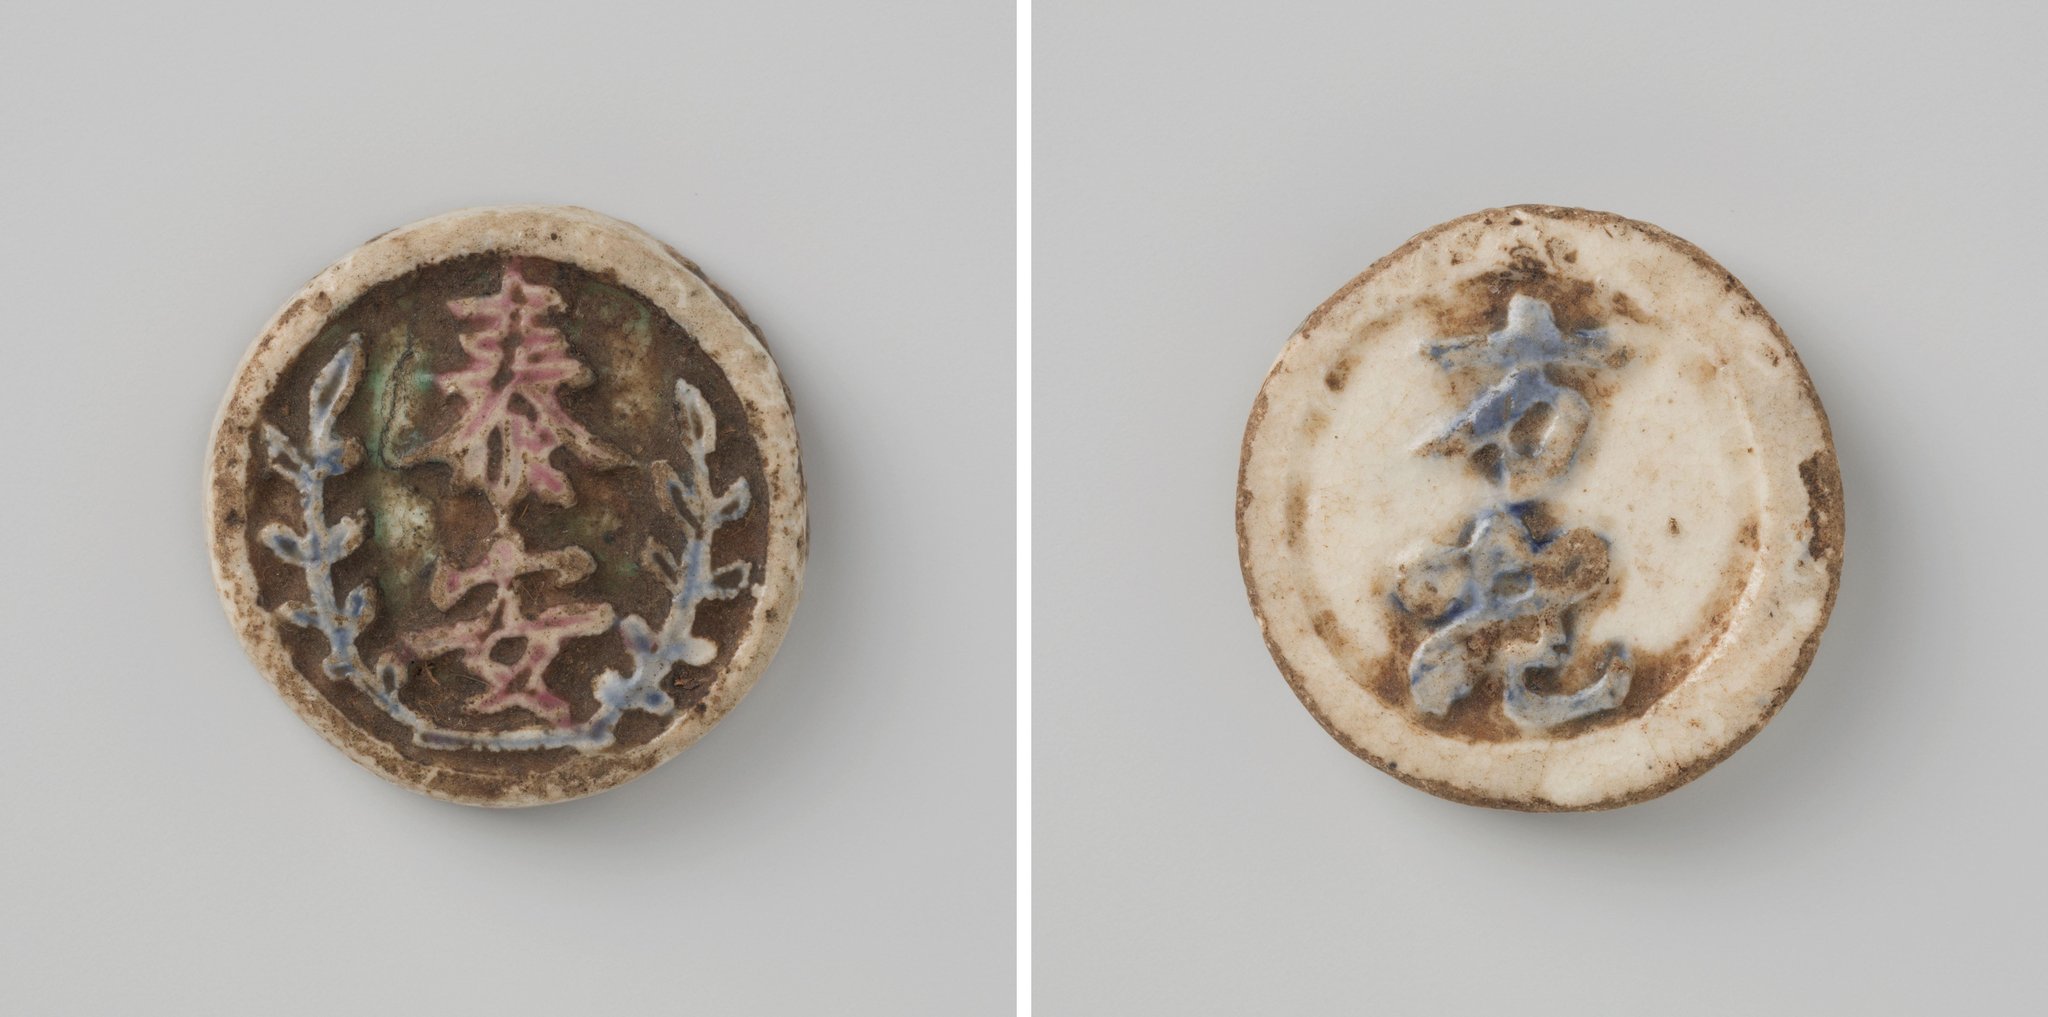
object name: coin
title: Speelhuispenning uit Thailand ter waarde van een fuang, 1760-1871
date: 1760-1871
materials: porcelain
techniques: firing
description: Ronde porseleinen speelhuispenning, die ook als munt is gebruikt. Voorzijde: tussen twee takken twee Chinese karakters. Keerzijde: twee Chinese karakters.